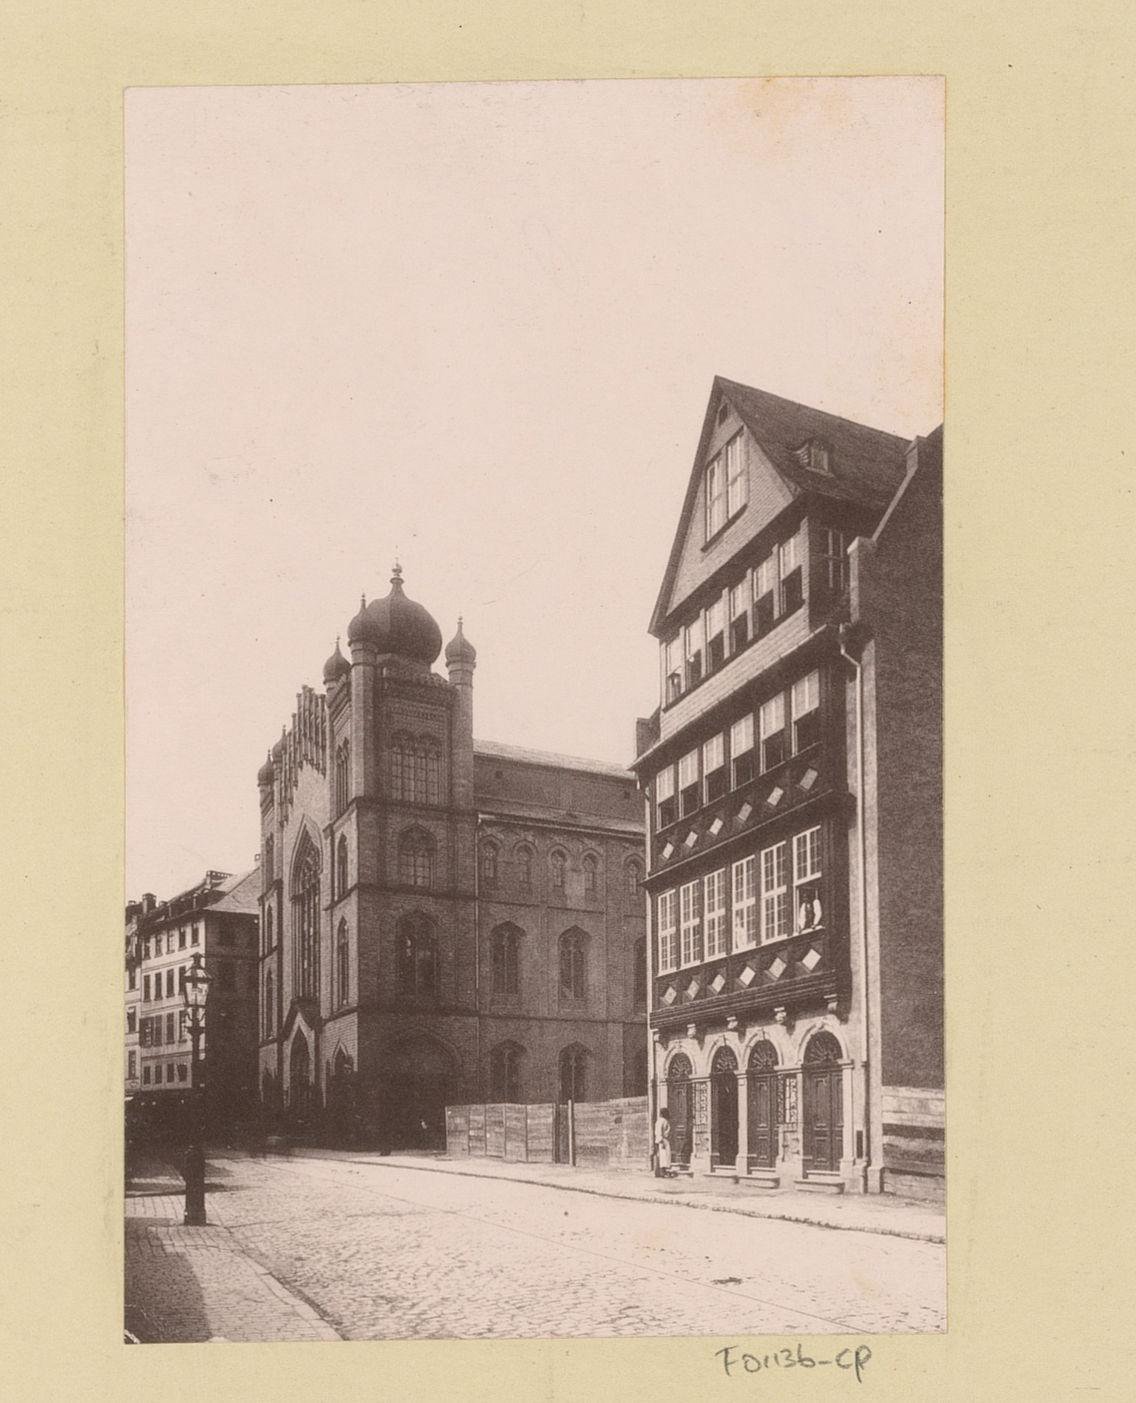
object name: photomechanical print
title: Straat in Frankfurt am Main met links de synagoge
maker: Anonymous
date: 1880-1895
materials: paper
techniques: photograph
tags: the synagogue (as building and place of worship ~ jewish religion), street (+ city(-scape) with figures, staffage)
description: Onderdeel van Fotoalbum met opnames van bezienswaardigheden in België, Duitsland en Noorwegen.